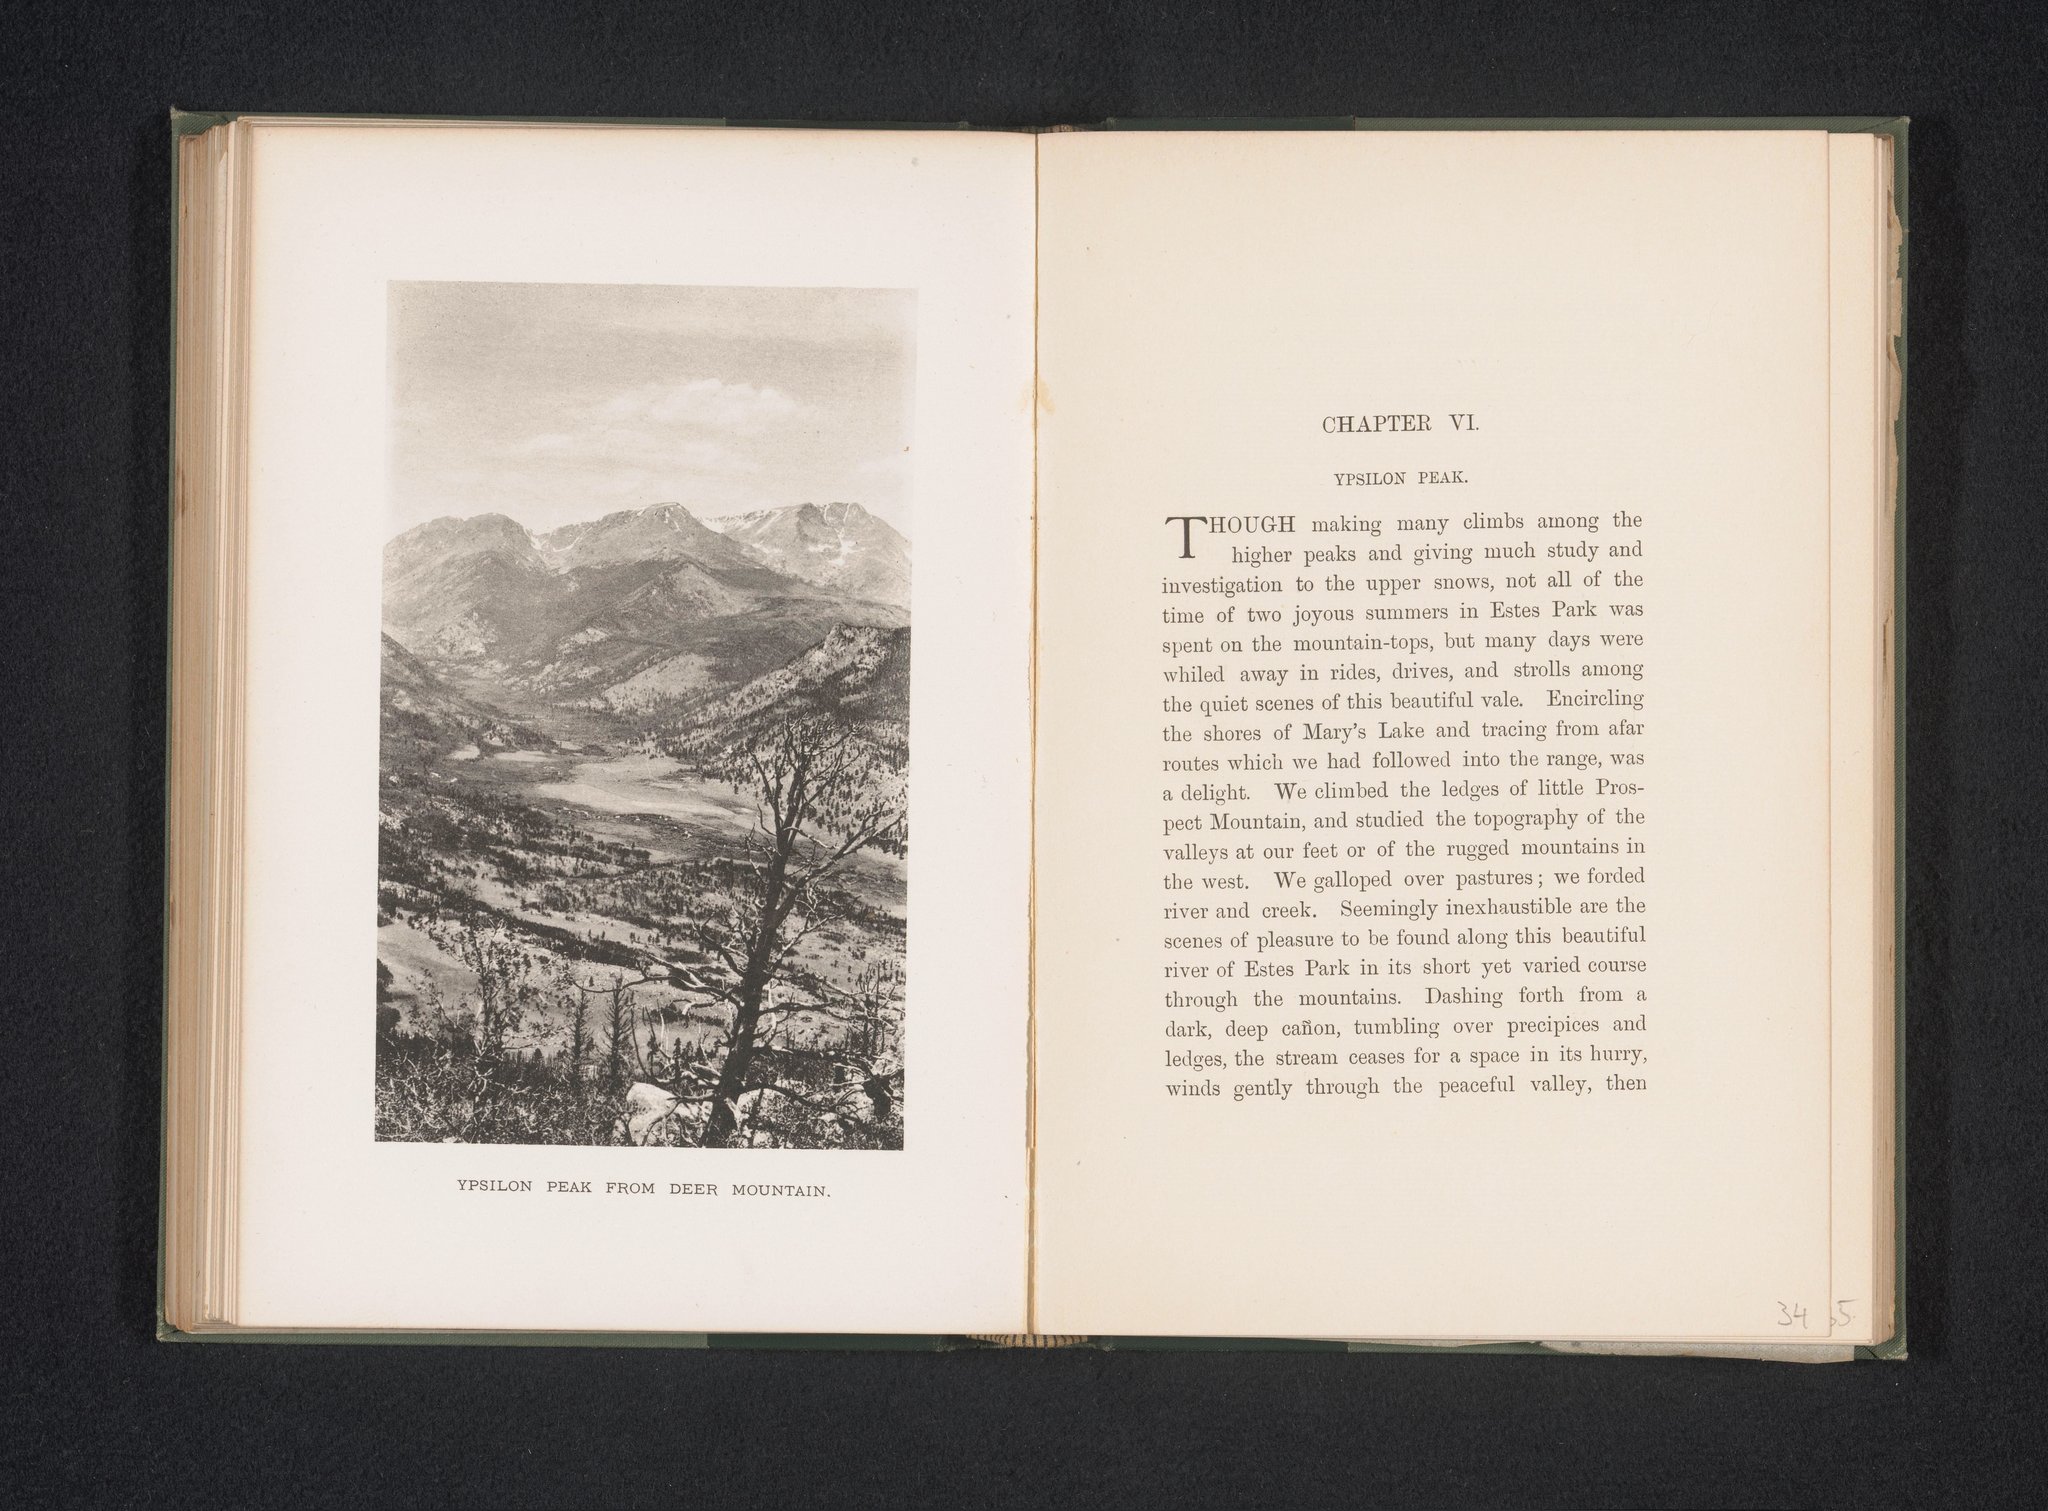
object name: photomechanical print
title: Gezicht op Ypsilon Peak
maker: frederick hastings chapin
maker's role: antropoloog, archeoloog, fotograaf, schrijver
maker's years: 1852-1900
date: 1885-1890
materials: paper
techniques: photograph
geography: deer mountain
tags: dale, valley, landscapes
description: Prent op tweede ongenummerde pagina na pagina 118.